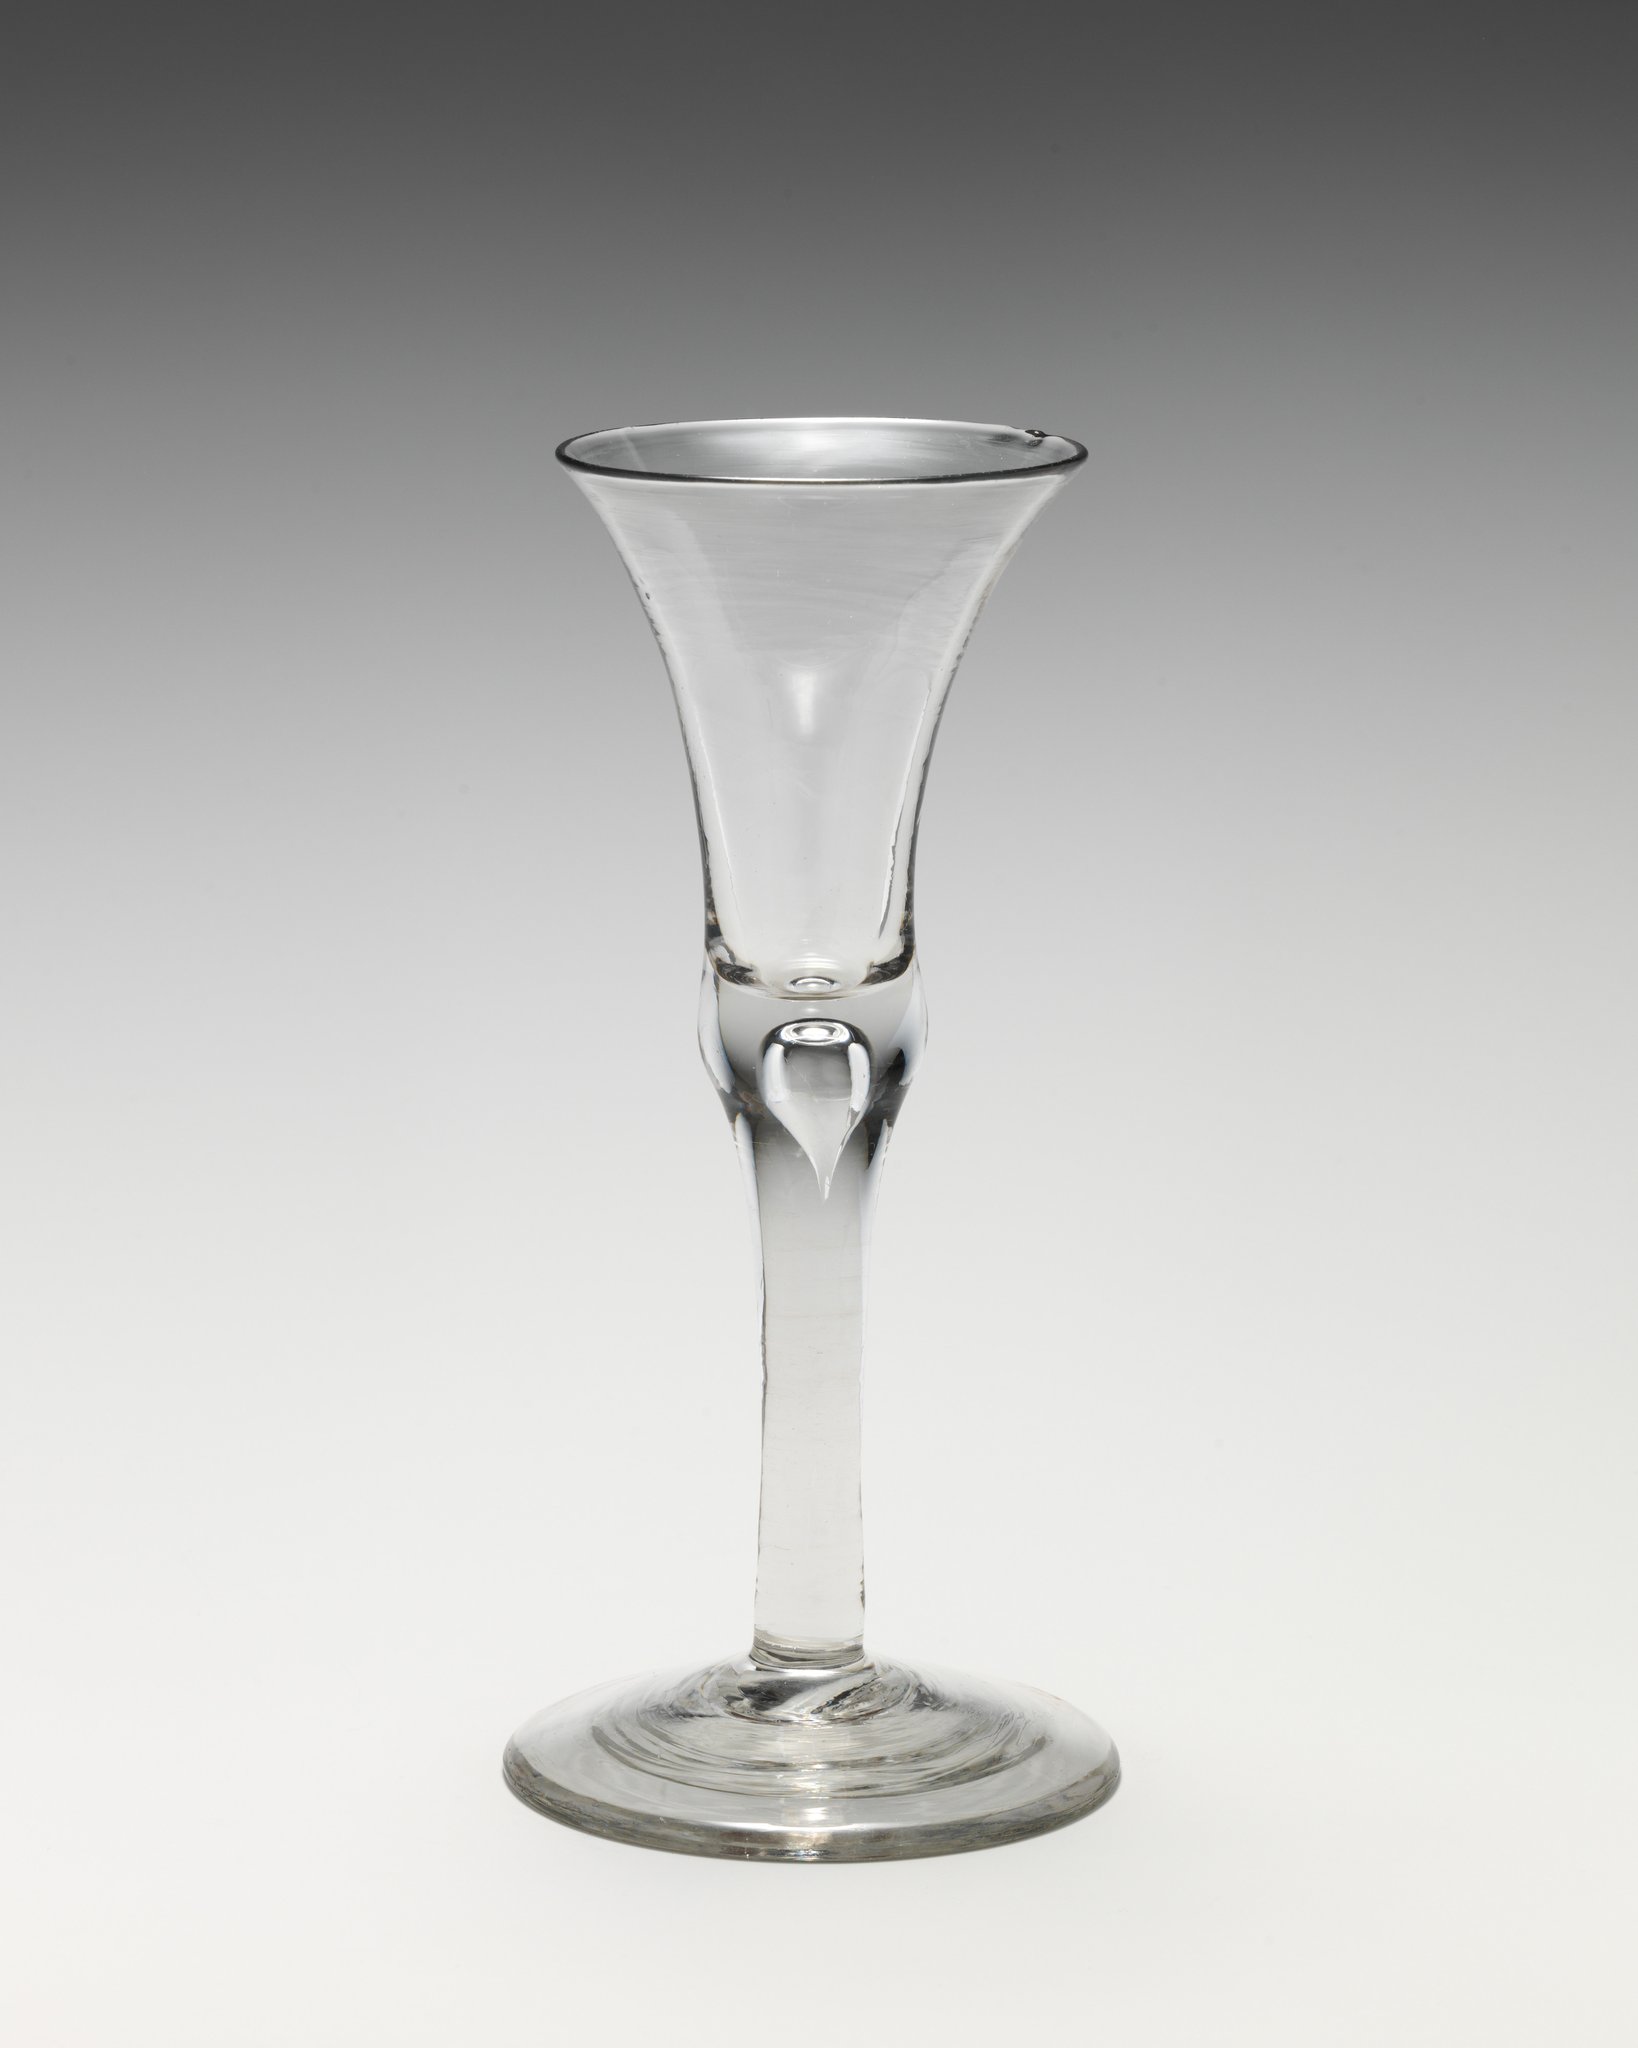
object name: wineglass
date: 1701-1750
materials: glass